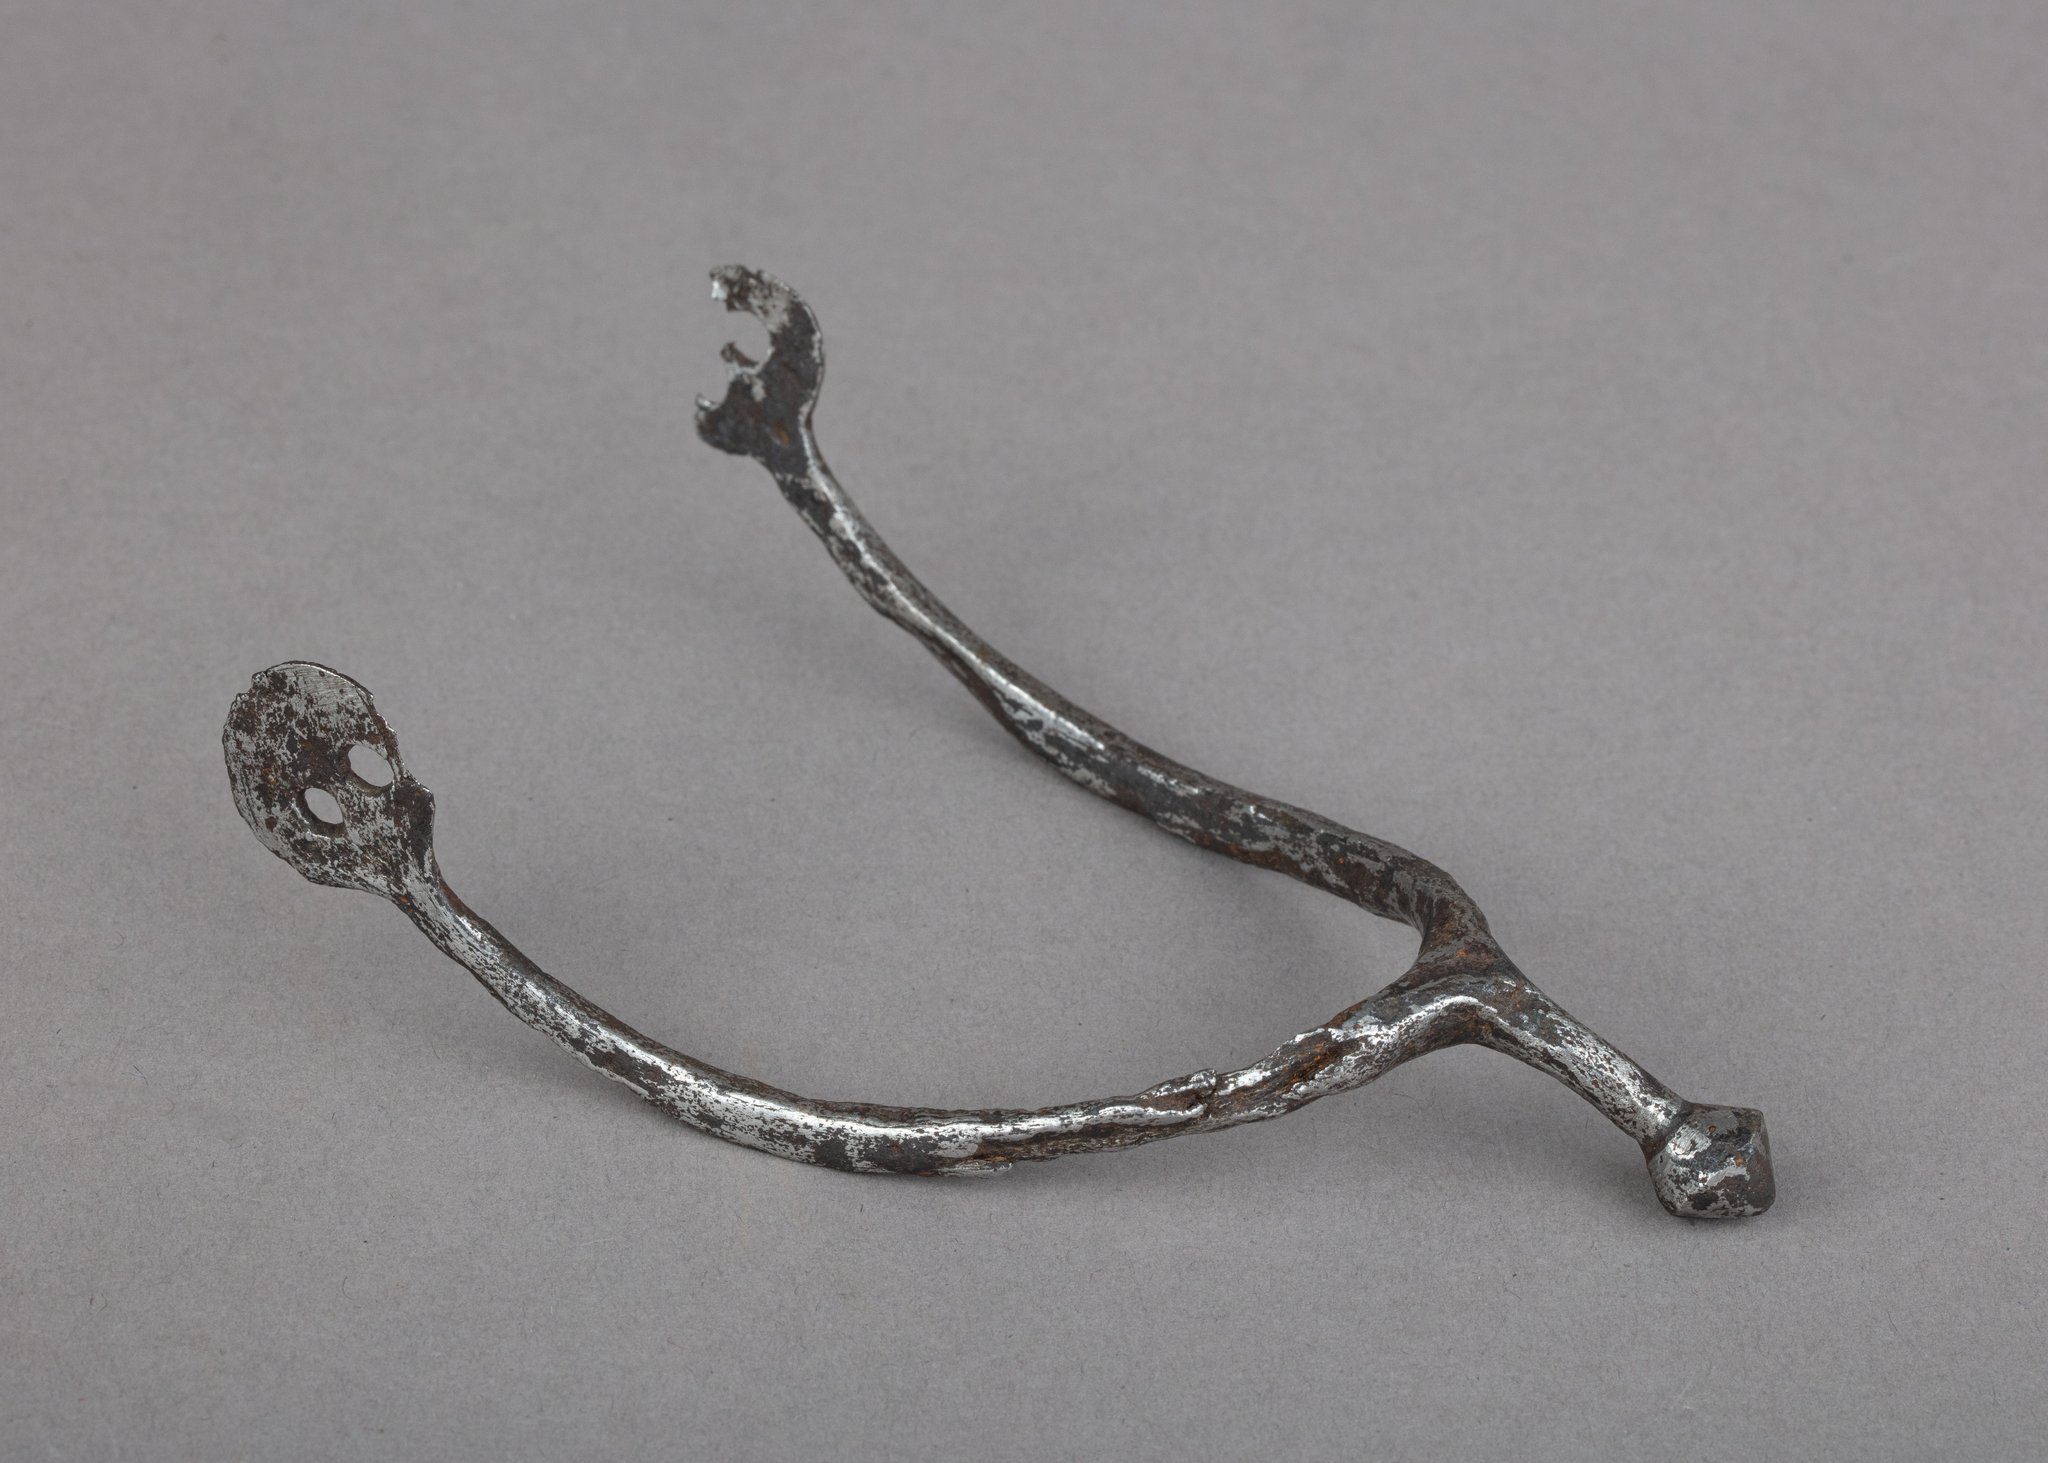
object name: spur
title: Prick Spur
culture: german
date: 1101-1300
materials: metal alloy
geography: poland